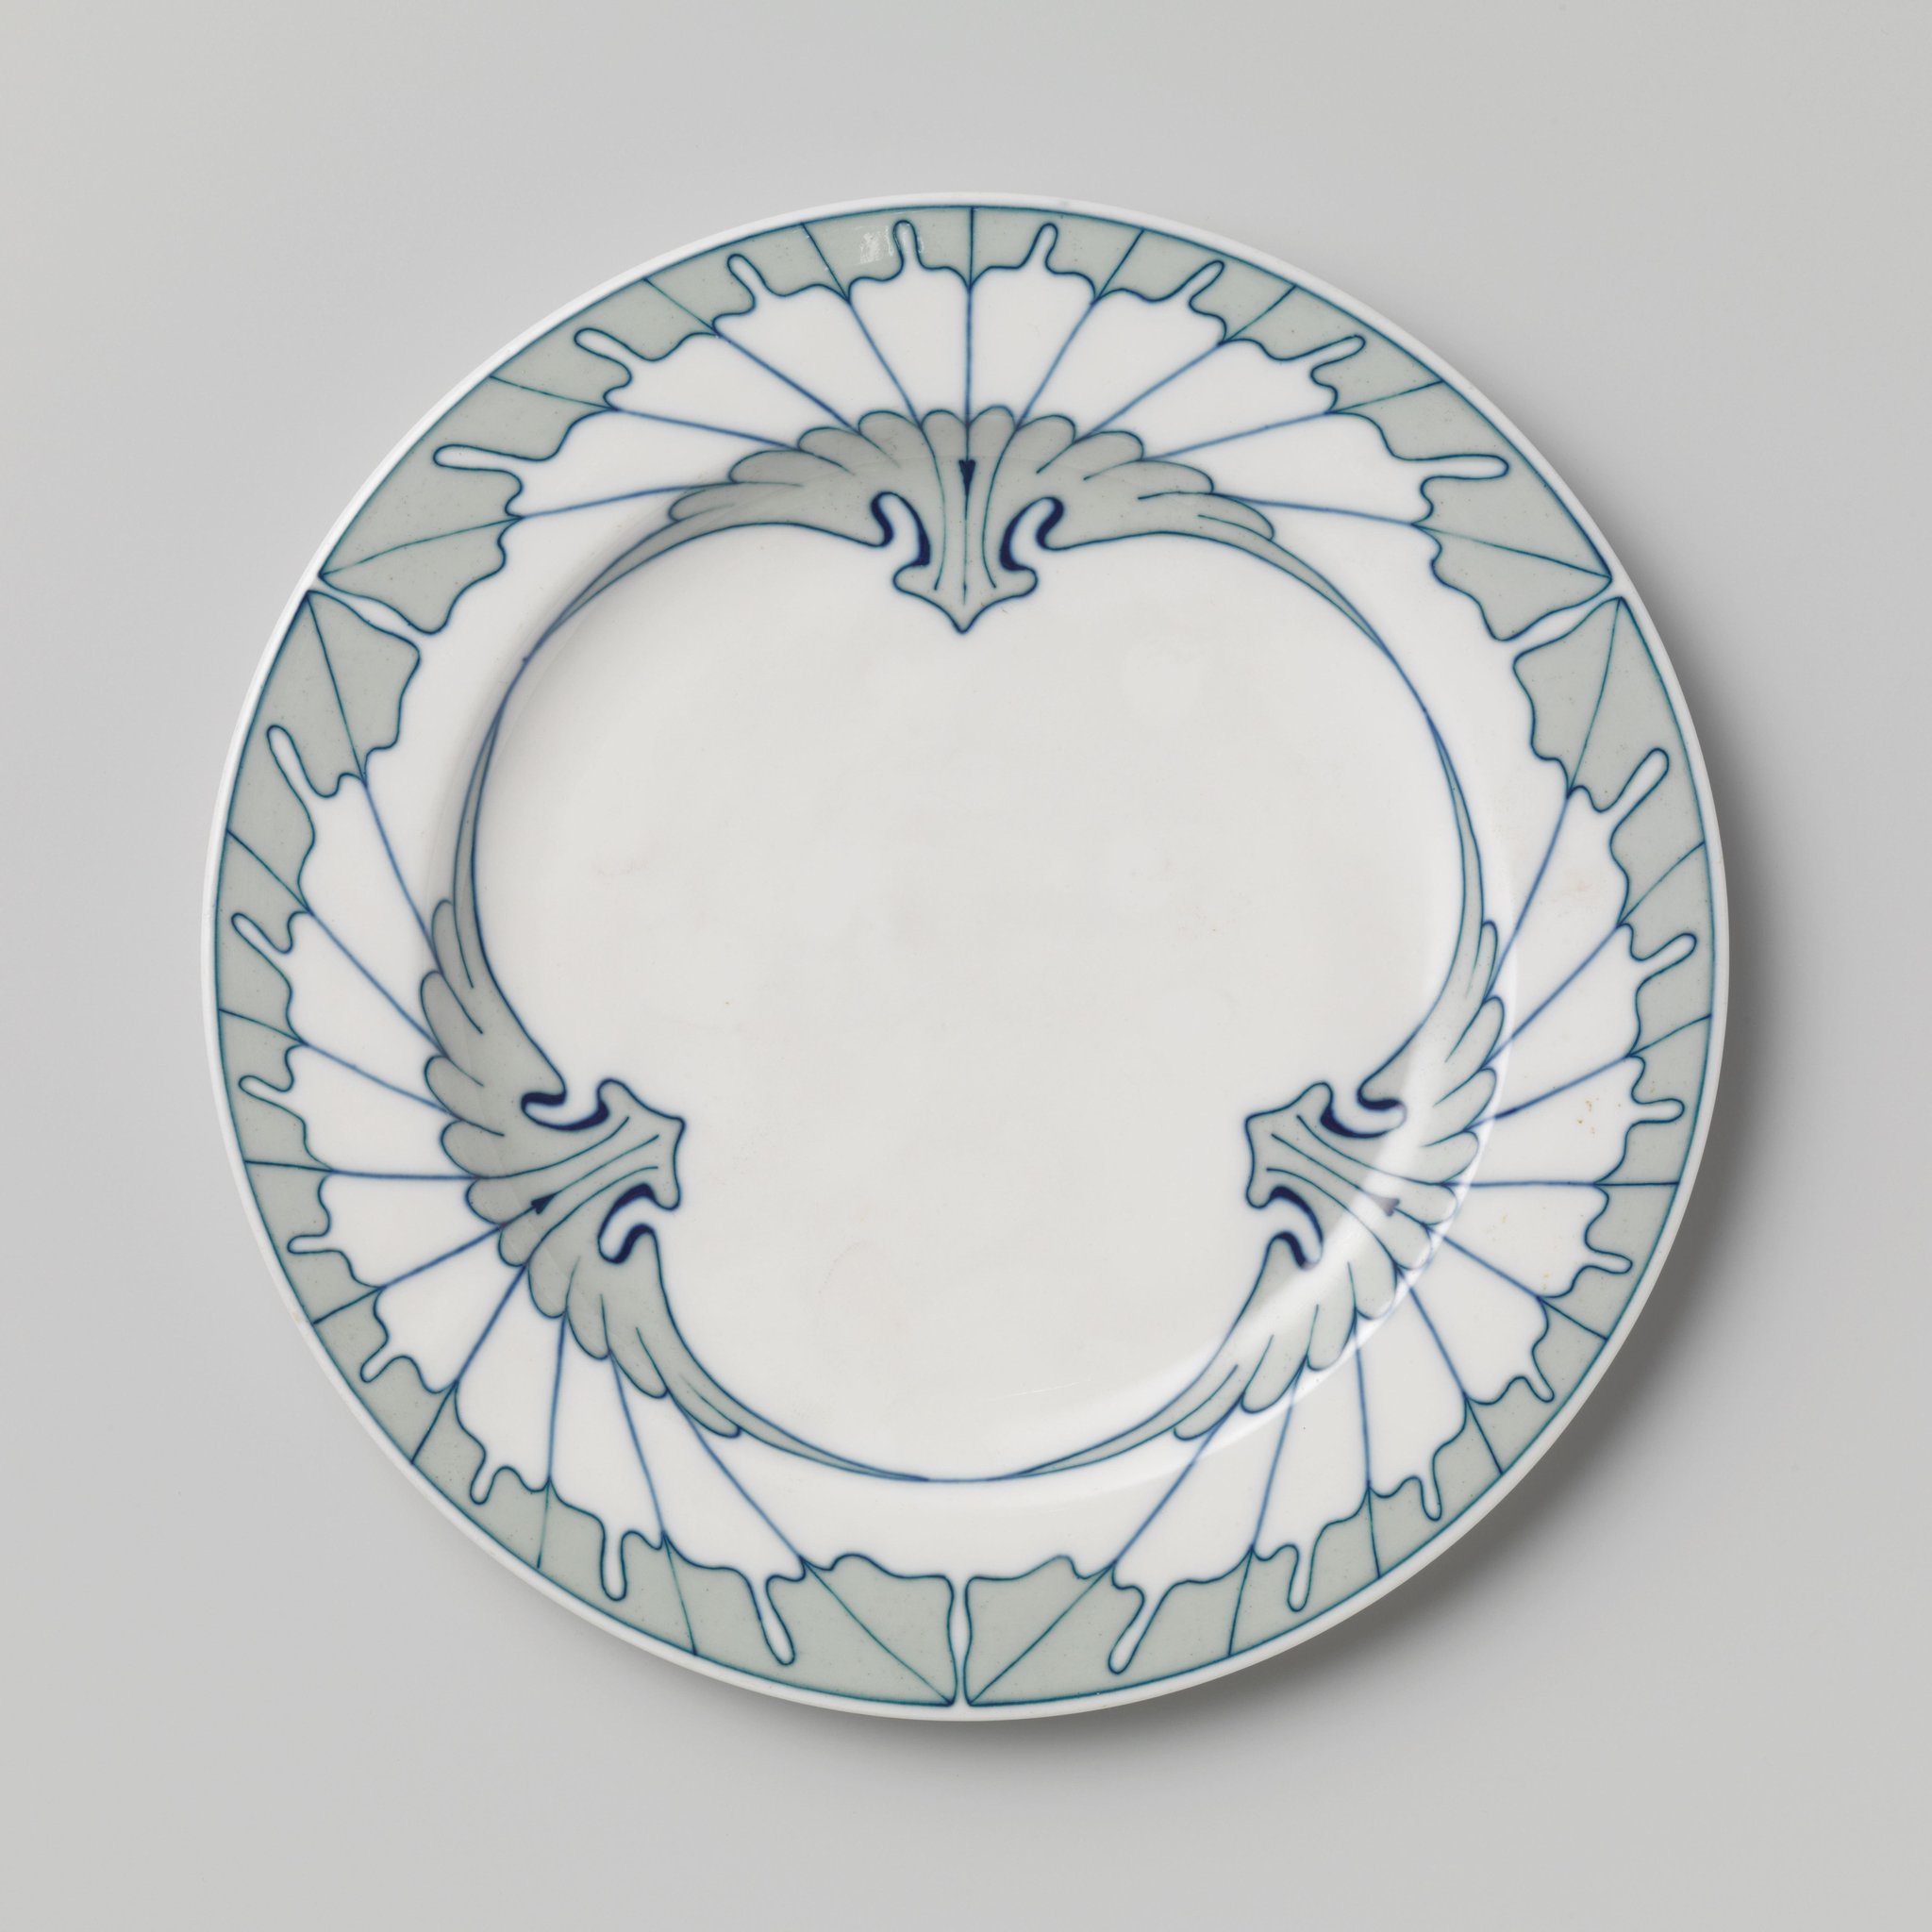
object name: plate dish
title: Bord, beschilderd met het Flügelmuster-decor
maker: konrad hentschel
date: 1901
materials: porcelain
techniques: painted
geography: meissen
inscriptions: factory mark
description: Bord van beschilderd porselein. Het bord is beschilderd in groen en blauw met het Flügelmuster. Het bord hoort bij een servies (BK-1976-65-1 t/m BK-1976-65-34) en is gemerkt.